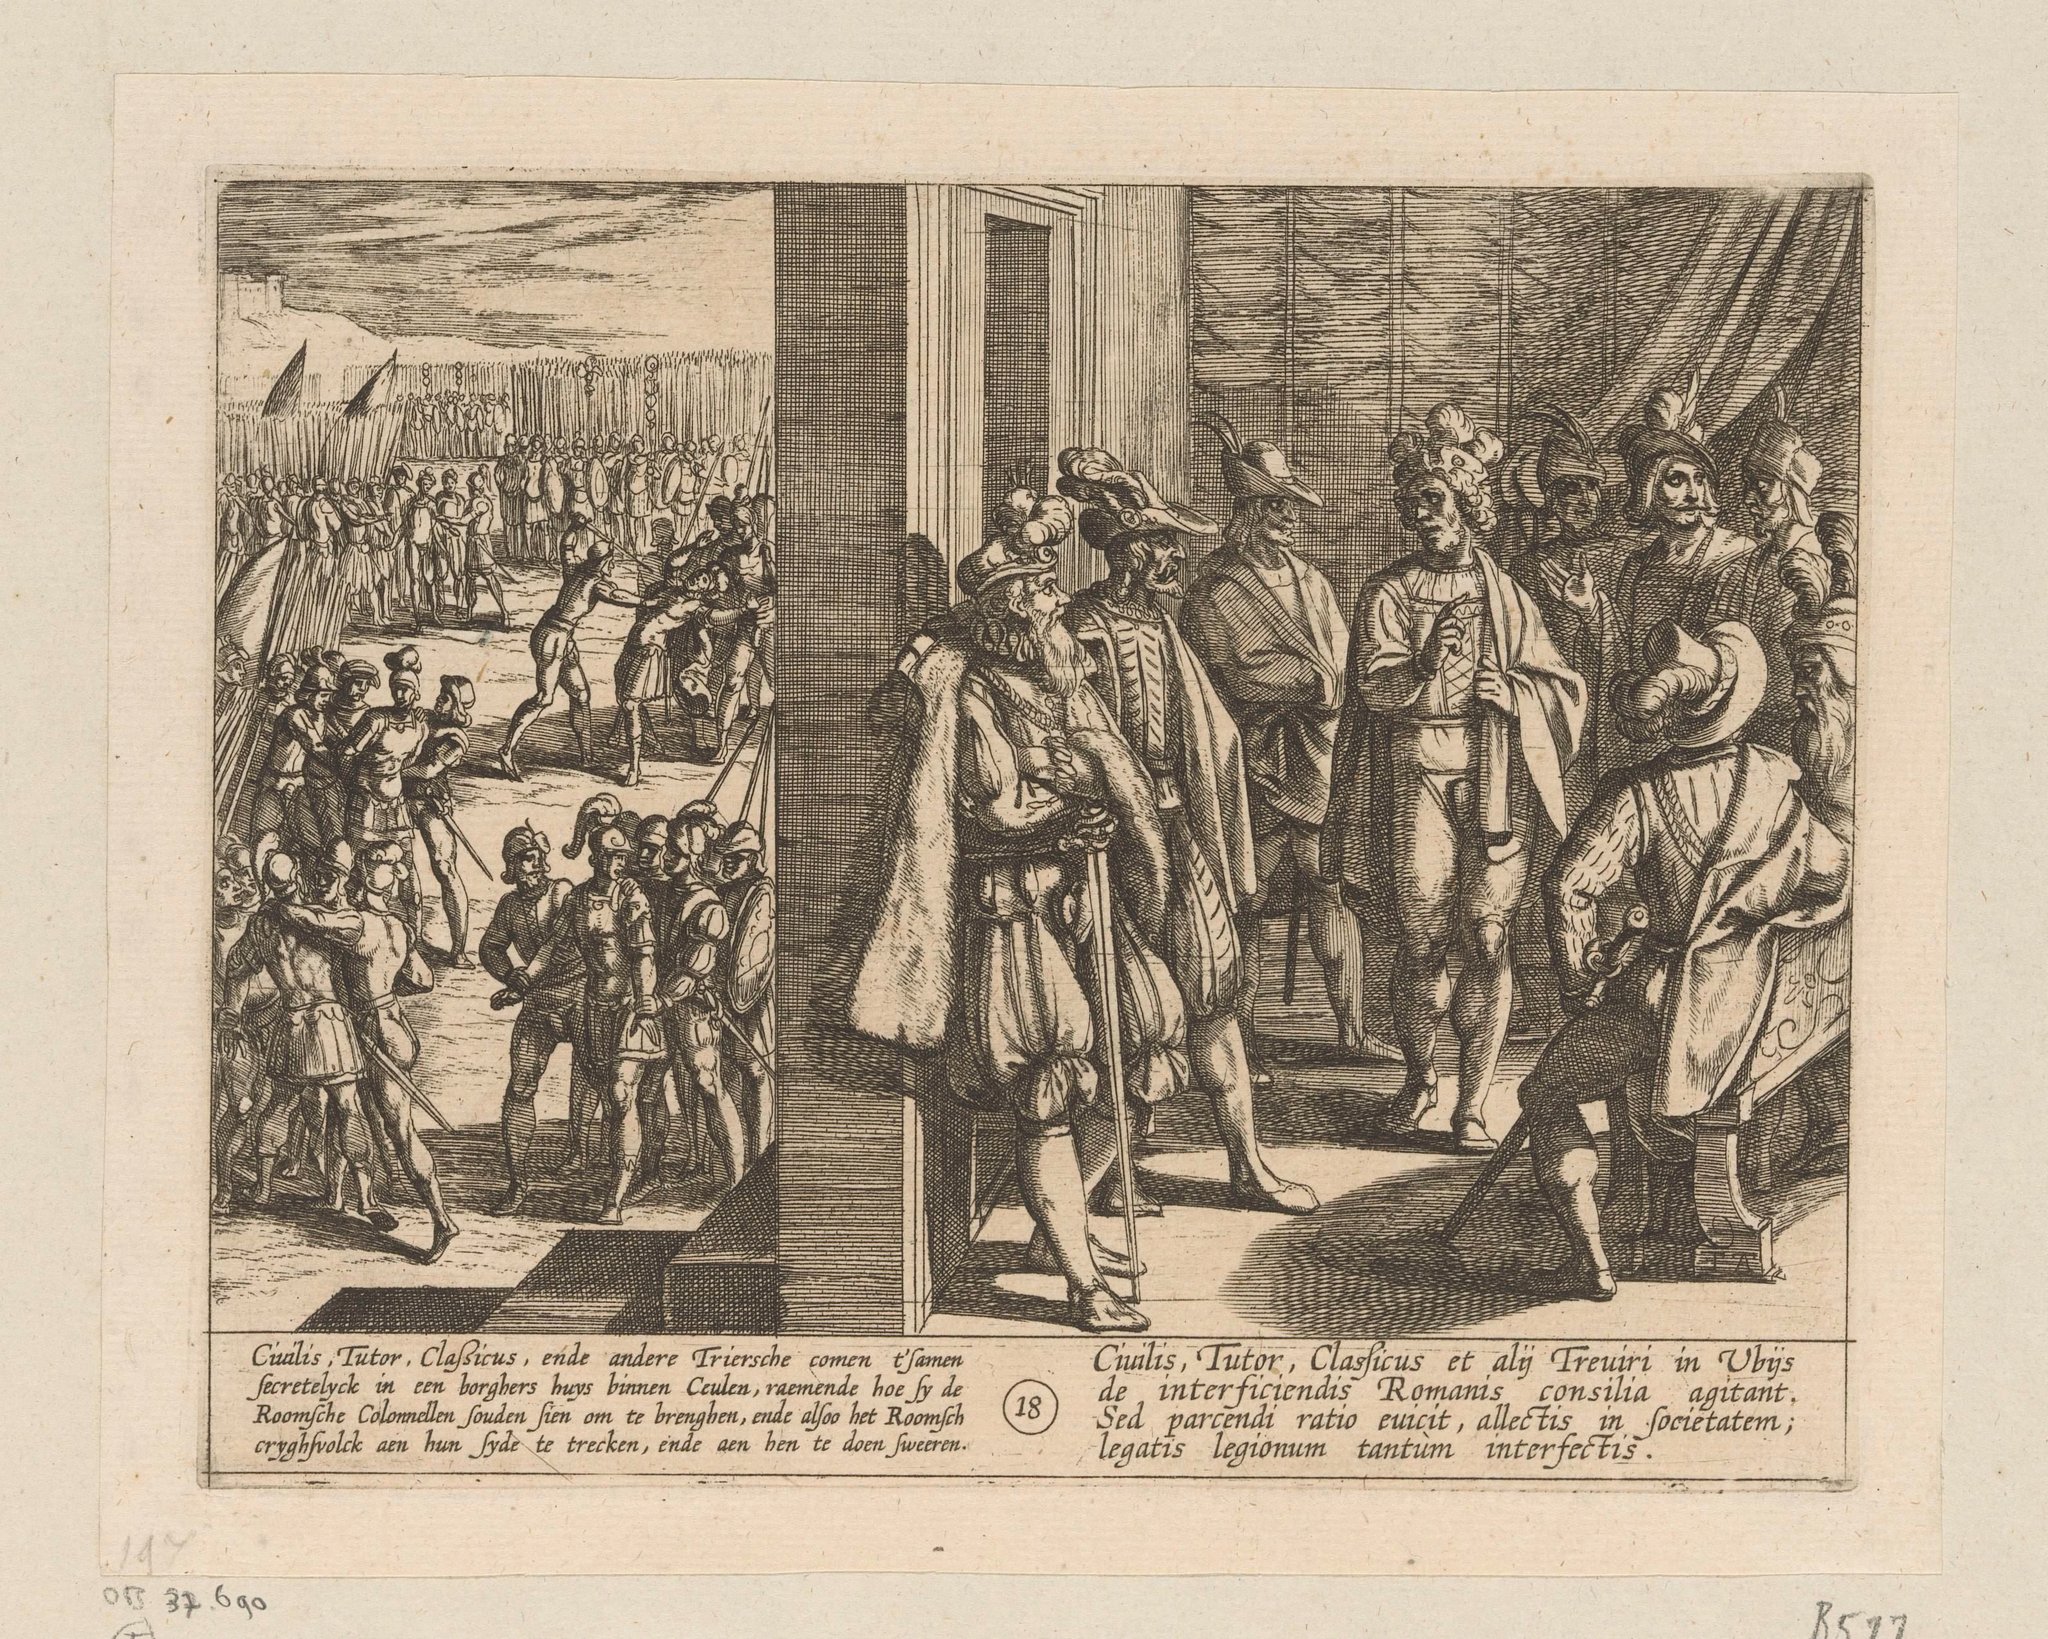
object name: history print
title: Geheime ontmoeting van Civilis met leiders van de Teviri, 69-70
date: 1612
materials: paper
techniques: etching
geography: italy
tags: extinct, 'historical' peoples (with name), cologne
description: Geheime ontmoeting van Civilis met Julius Classicus en Julius Tutor, leiders van de Treviri uit Trier in een huis te Keulen. Hierij wordt een plan beraamd om de Romeinse officieren te doden om zo de soldaten aan hun zijde te krijgen. Prent nummer 18 in de serie prenten over de Bataafse Opstand: Batavorum cum Romanis bellum / à Corn. Tacito lib. IV & V. : Hist. olim descriptum, figuris nunc aeneis expressum, auctore Othone Vaenio Lugdunobatava = De Batavische oft oude Hollandtsche oorloghe teghen de Romeynen. Otto Vaenius, Antwerpen 1612. Onderaan twee verzen van vier regels in het Nederlands en in het Latijn. Zonder tekst op achterzijde.